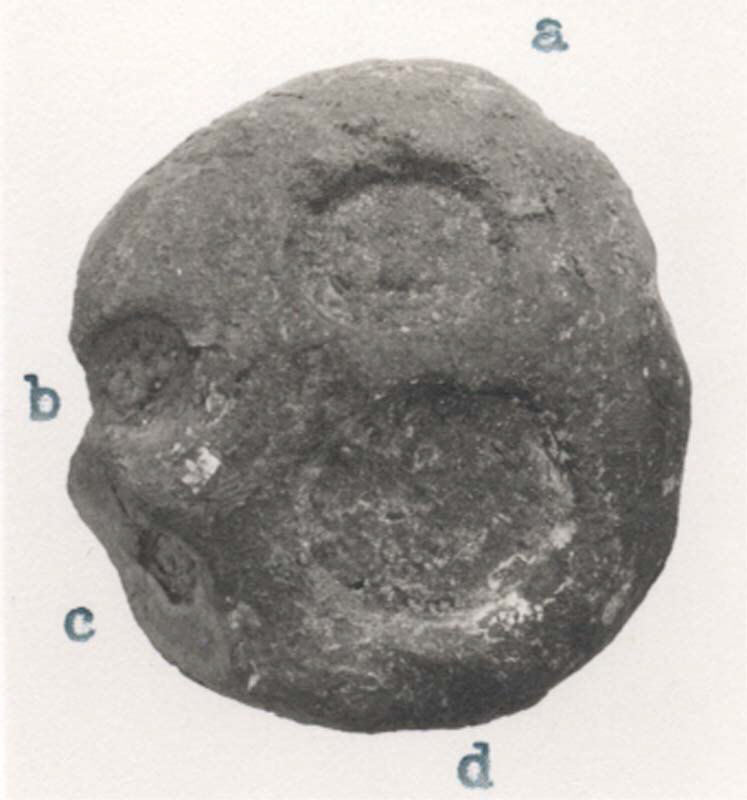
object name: sealing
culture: sasanian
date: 601-700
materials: clay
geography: iran